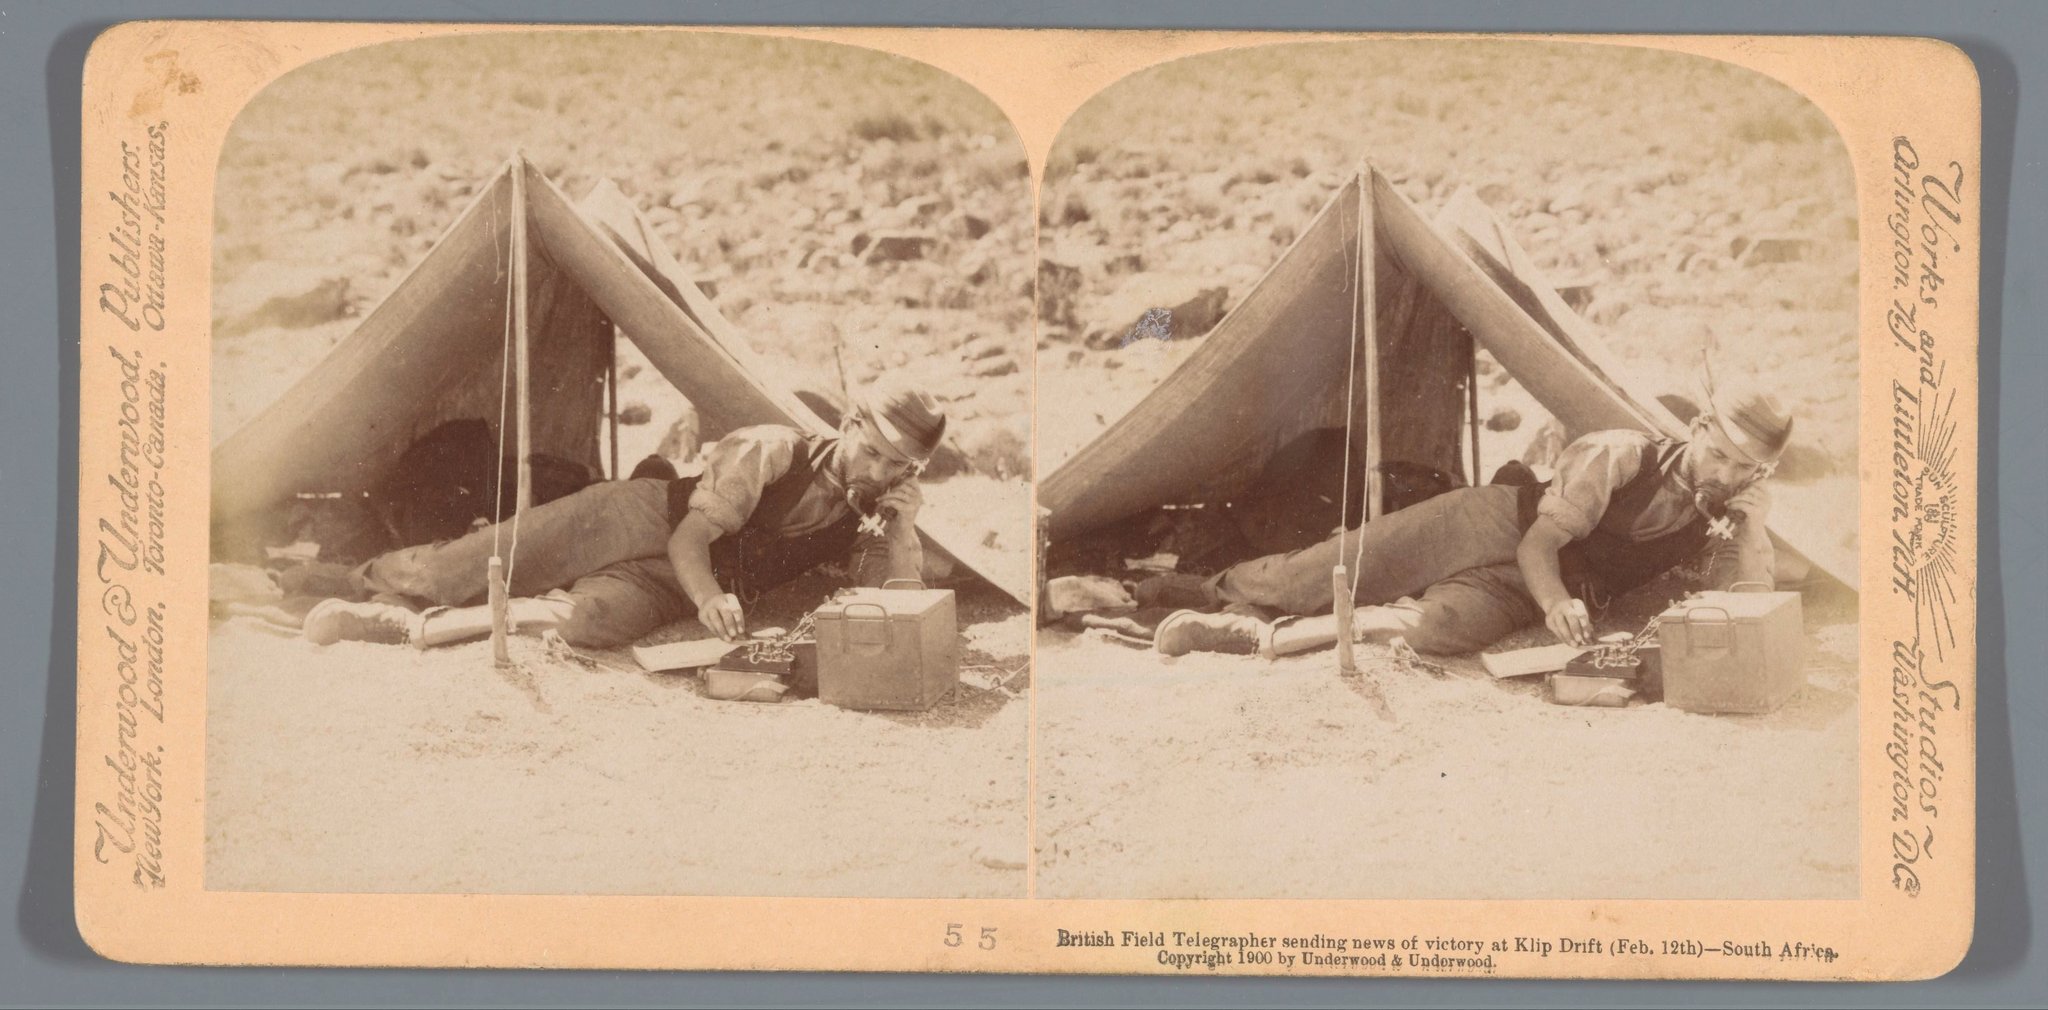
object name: stereograph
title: Voorstelling van een soldaat liggend voor een tent in Klipdrift, 12 februari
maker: Anonymous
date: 1900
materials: cardboard, paper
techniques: albumen print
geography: new york city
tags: (military) camp with tents, (morse) telegraph, the soldier; the soldier's life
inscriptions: inscription, number: ‘55’, inscription: ‘Works and Studios ~/ Arlington, N.J. Littleton, N.H. Washington, D.C.’, copyright notice: ‘Copyright 1900 by Underwood and Underwood.’